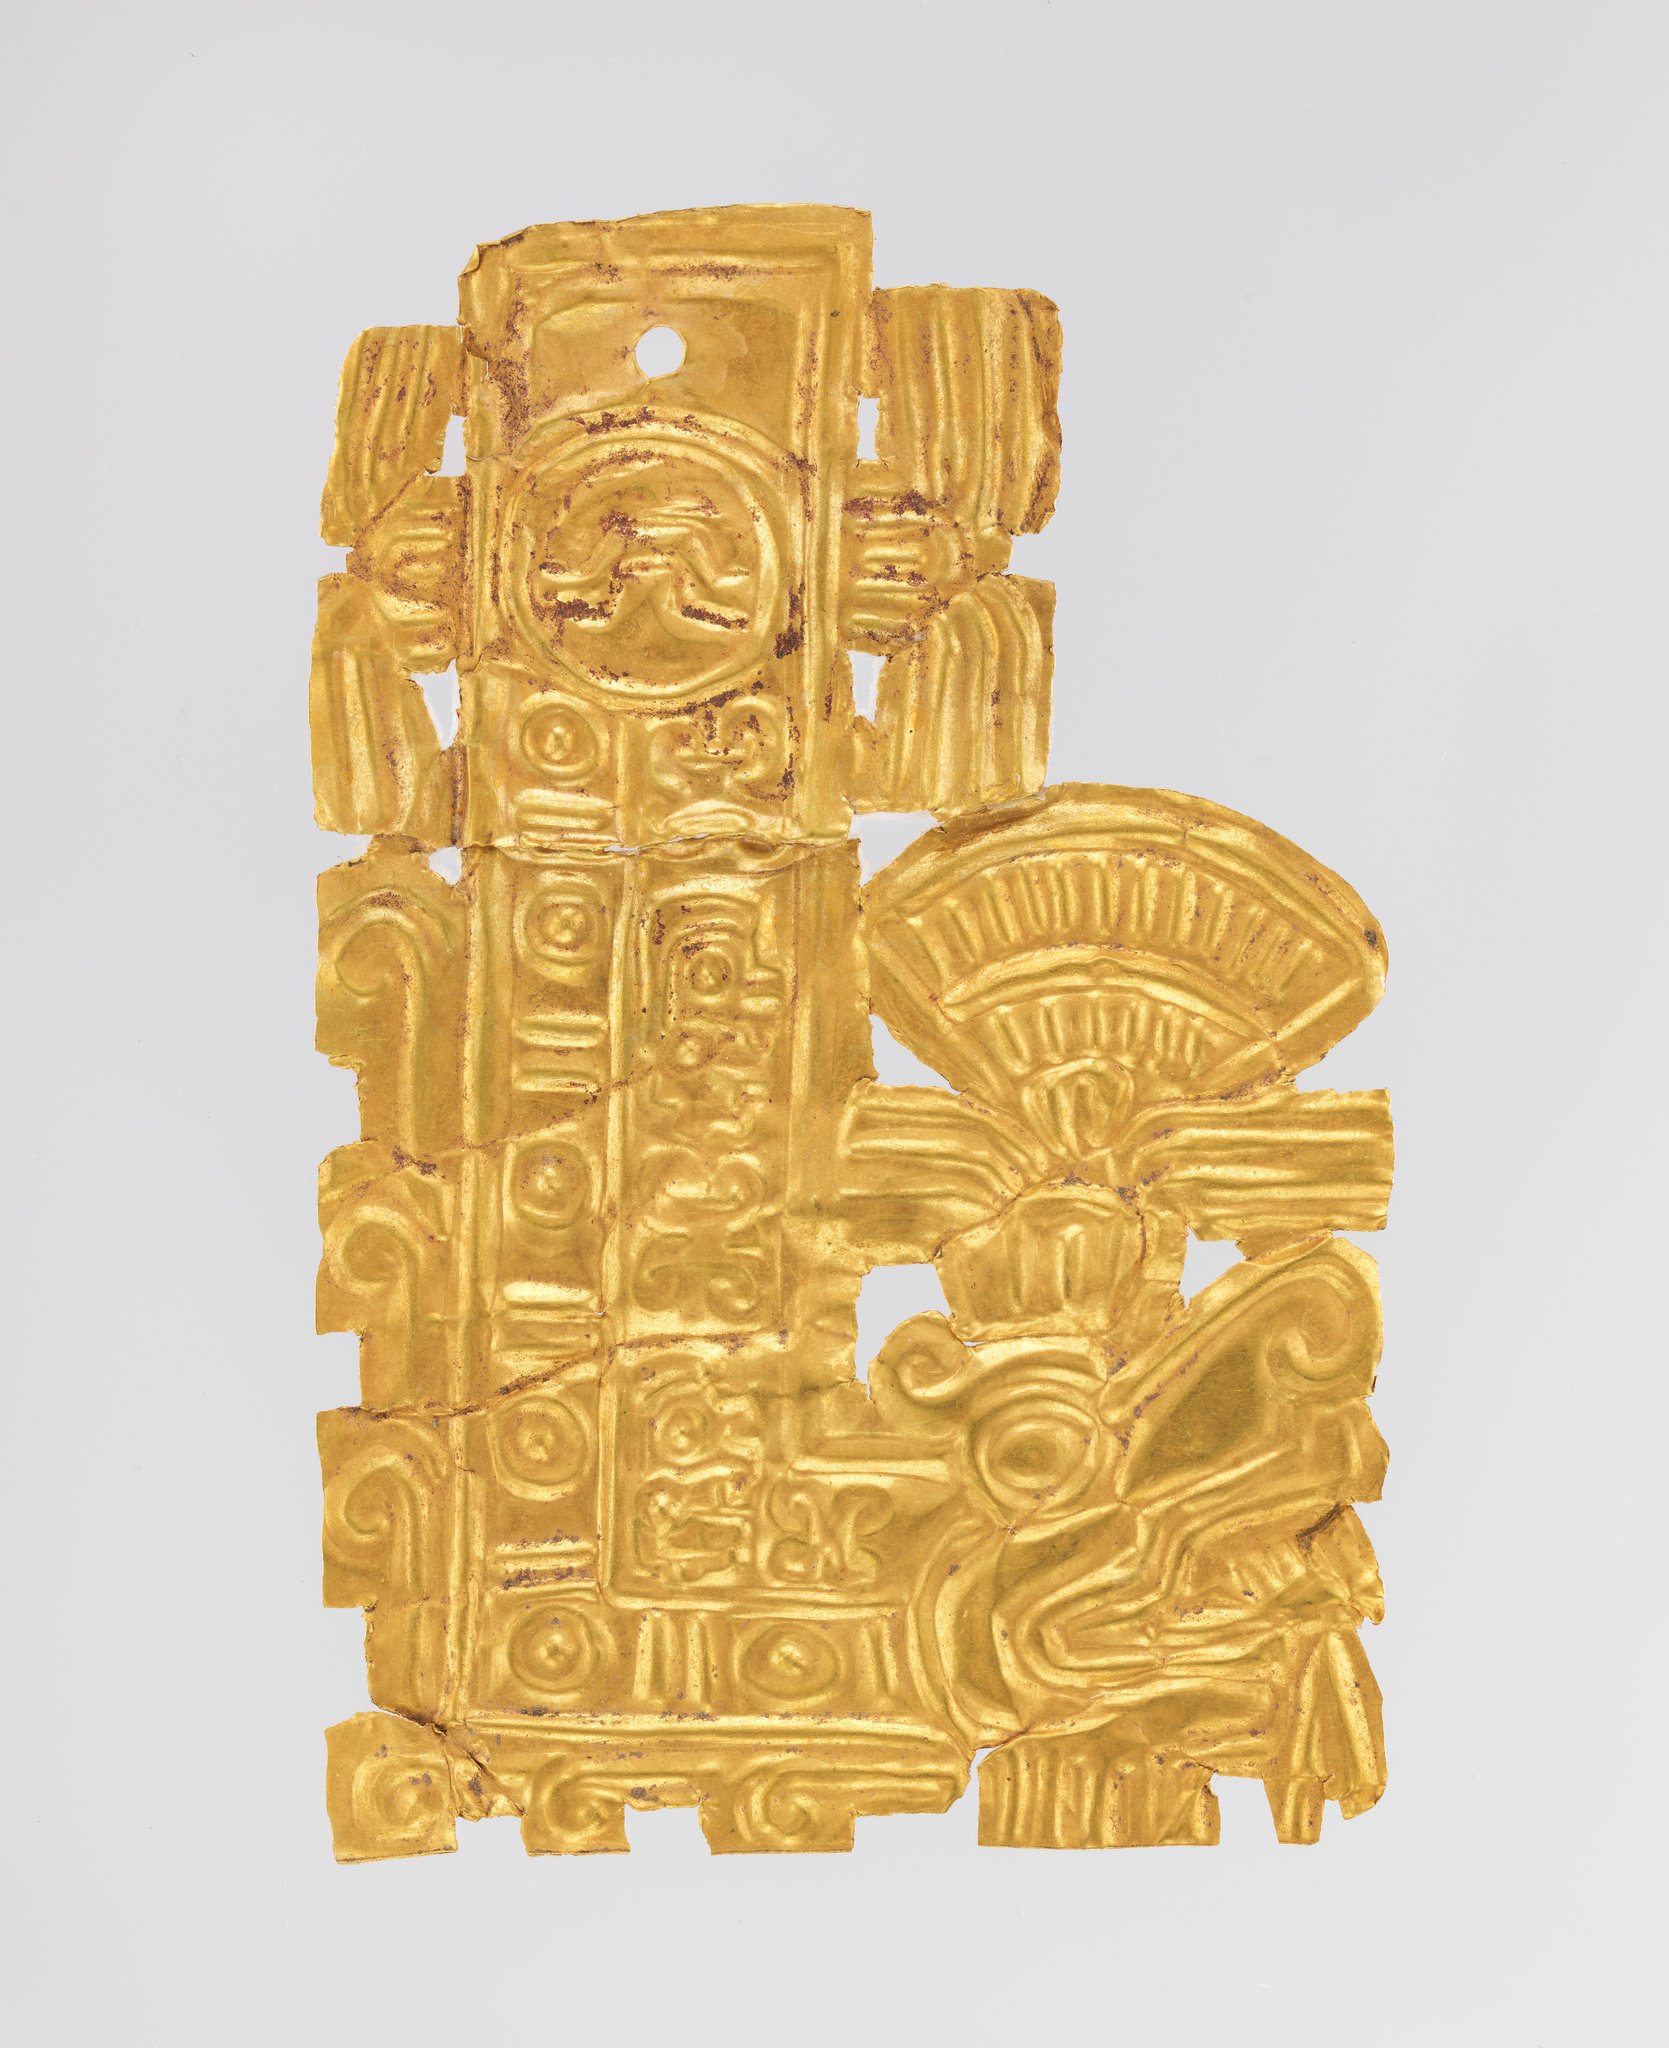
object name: ornament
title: Feathered serpent ornament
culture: mexica, aztec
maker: mexica or mixtec (ñuu savi) artists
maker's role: artist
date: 1325-1521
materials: gold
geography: mexico